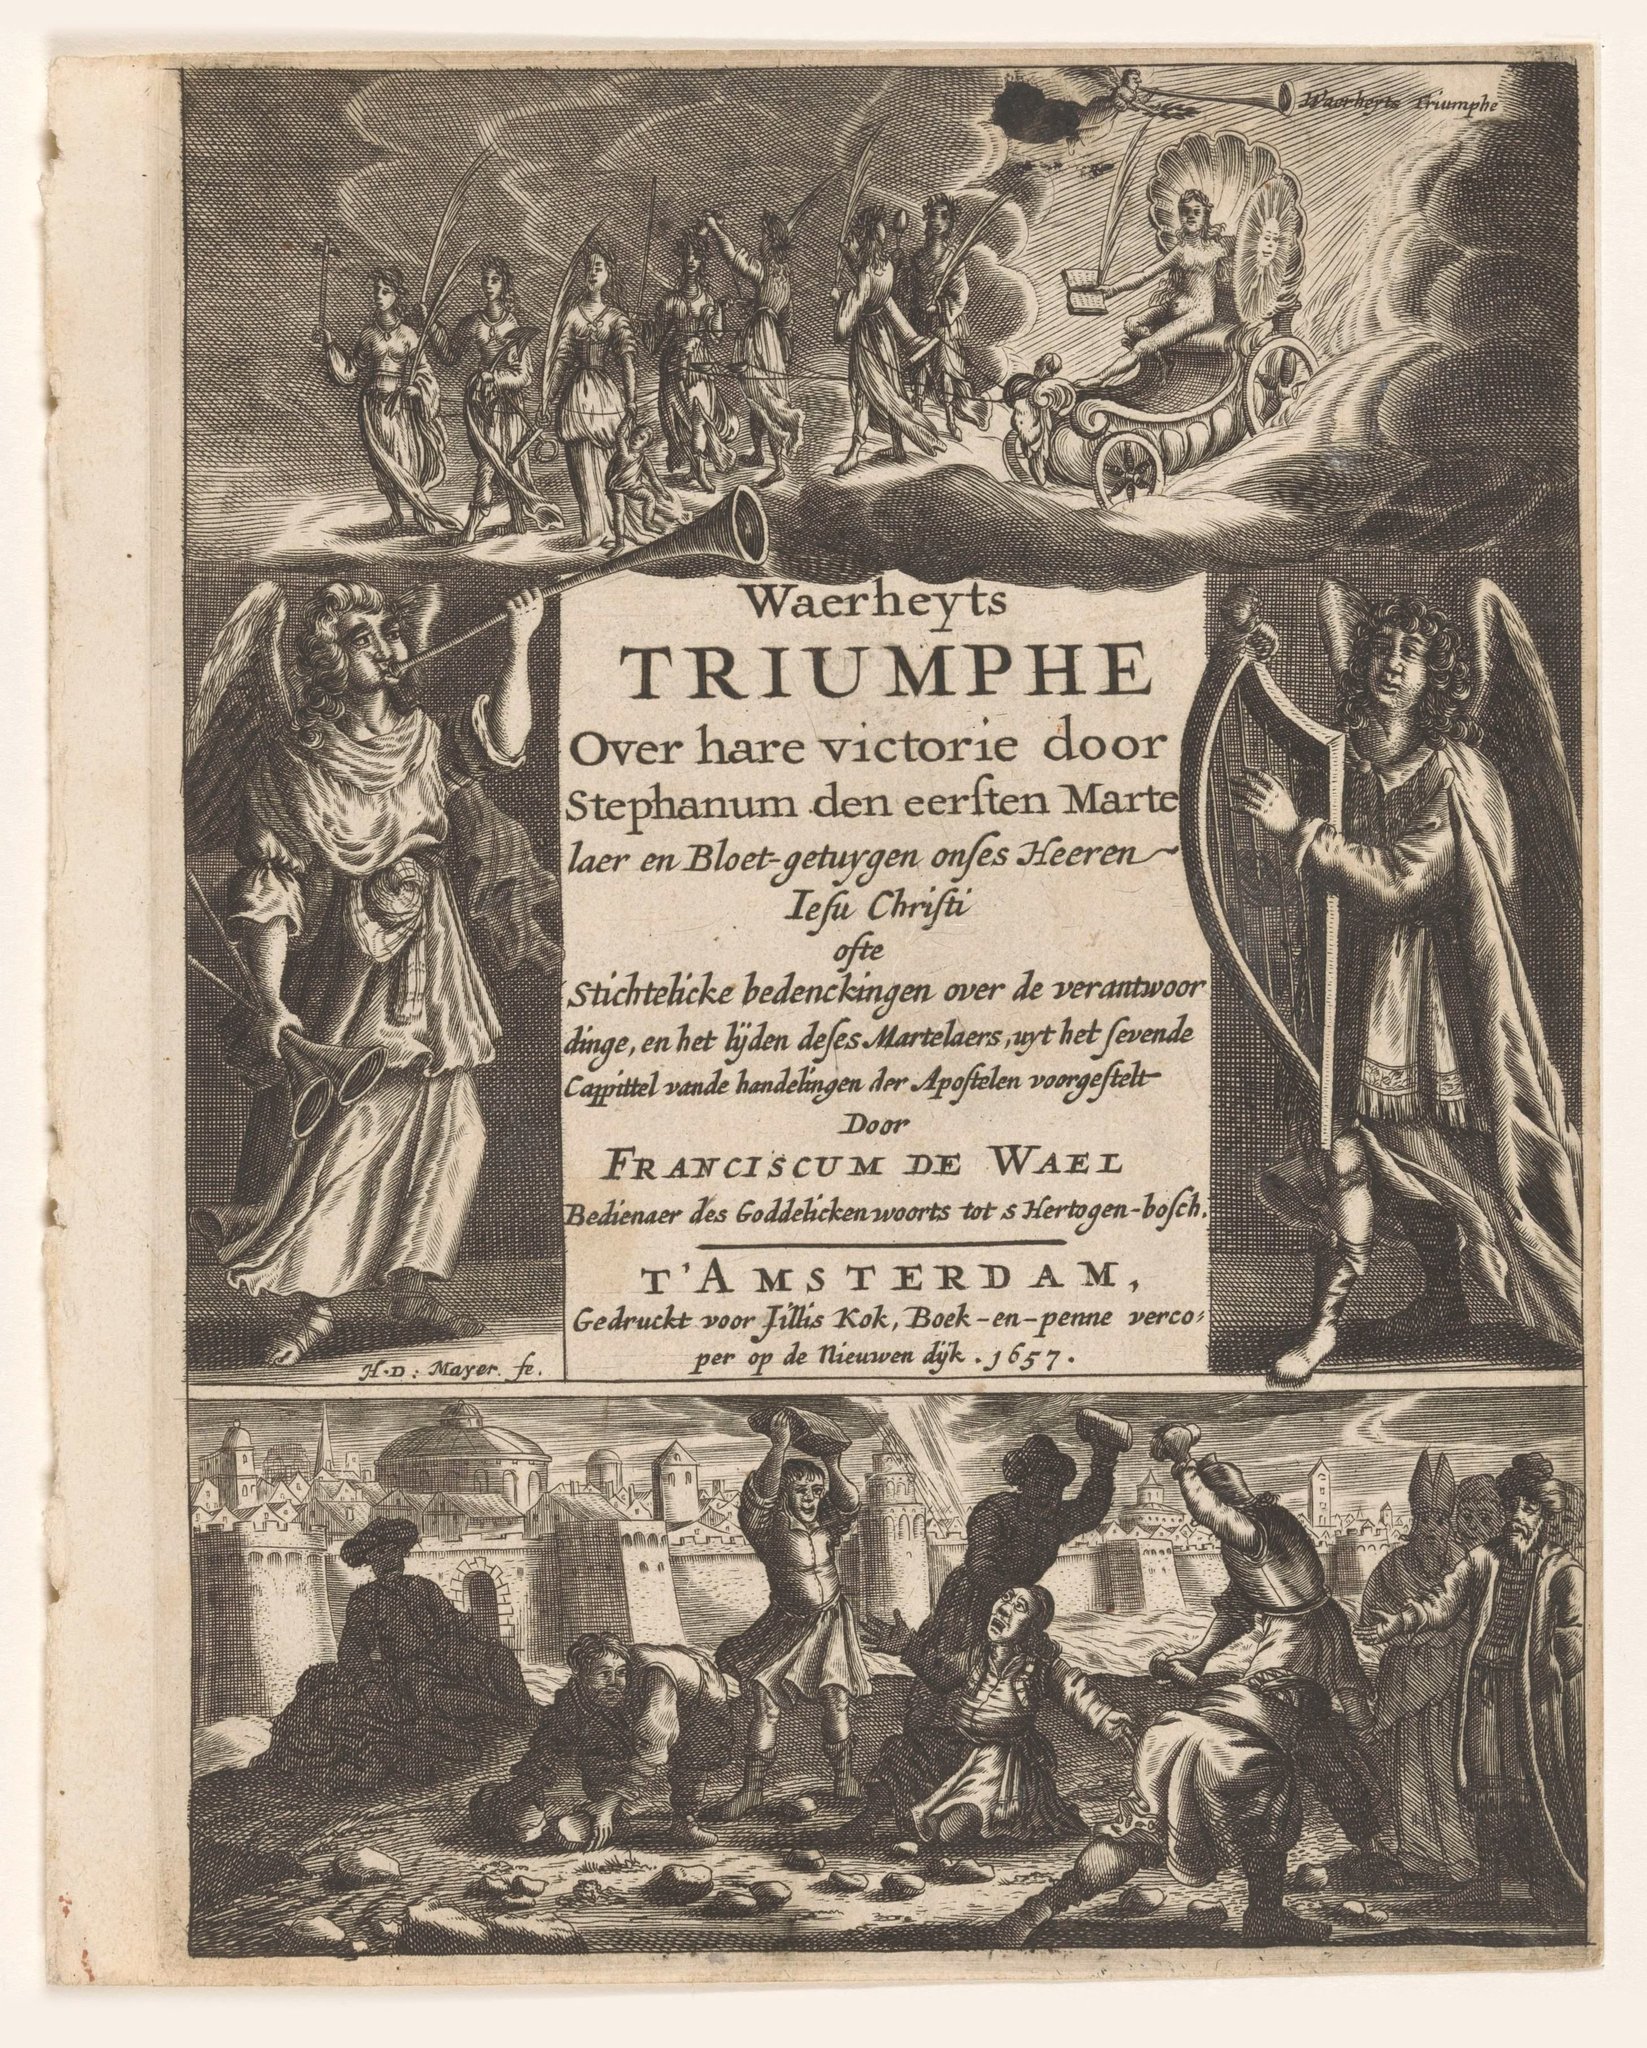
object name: titelblad, titelpagina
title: Triomf van Waarheid en steniging van Stefanus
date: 1657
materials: paper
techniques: engraving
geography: amsterdam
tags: martyrdom and death of stephen, truth; 'verità' (ripa)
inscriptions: collector's mark: Lugt 2228, collector's mark: Lugt 2760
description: Waarheid in triomfwagen wordt voortgetrokken door zeven vrouwen. Daarboven vliegt Fama. Daaronder de titel van het boek geflankeerd door twee engelen met bazuinen en een harp. Aan de onderzijde de steniging van Stefanus.